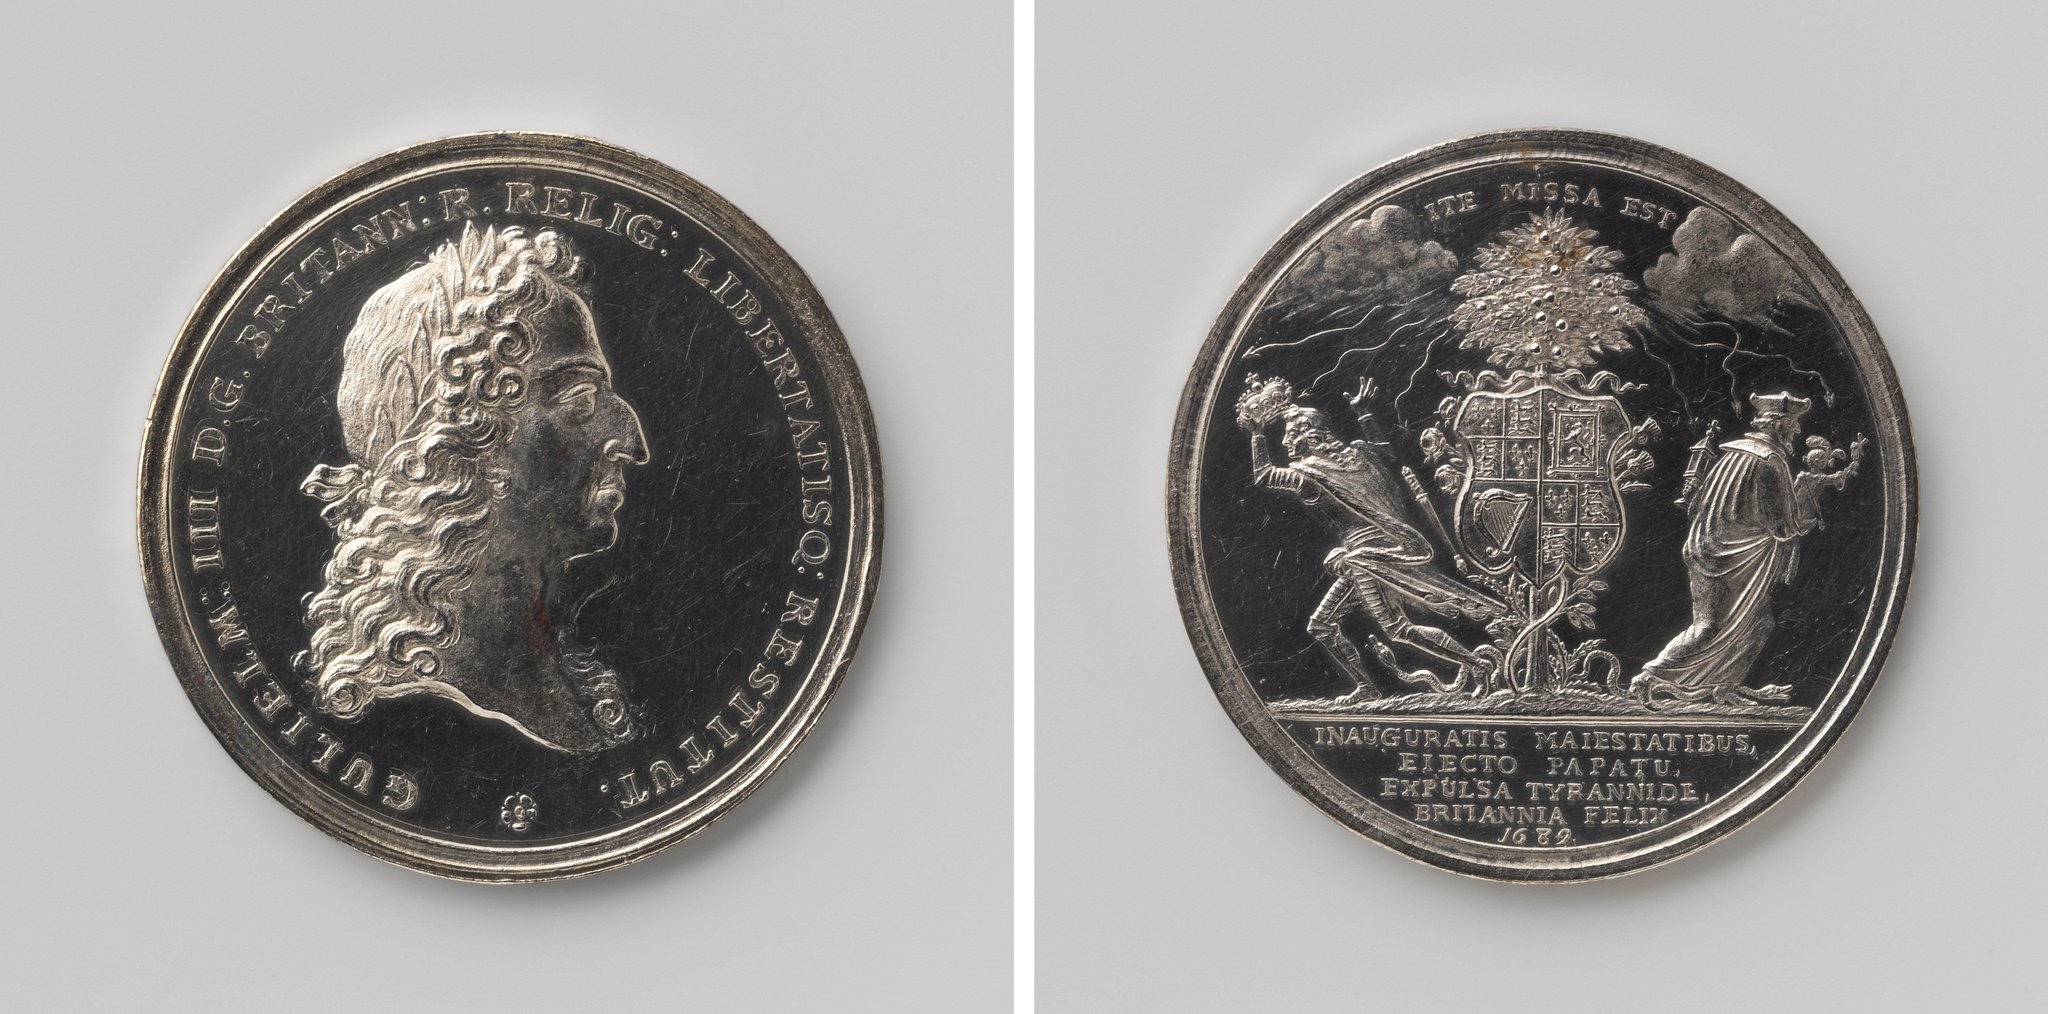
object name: history medal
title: Kroning van Willem III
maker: jan smeltzing (i)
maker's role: modelleur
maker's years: 1656-1693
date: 1689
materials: silver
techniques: striking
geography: leiden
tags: the hague, william iii (prince of orange and king of england, scotland, and ireland)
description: Zilveren penning. Voorzijde: borststuk man met lauwerkrans binnen omschrift. Keerzijde: wapenschild van Groot-Britannie hangend aan oranjeboom met rozen. Bliksem uit wolken verdrijft Jacobus II, die zijn kroon wegwerpt en Jezuit met kind op arm binnen omschrift